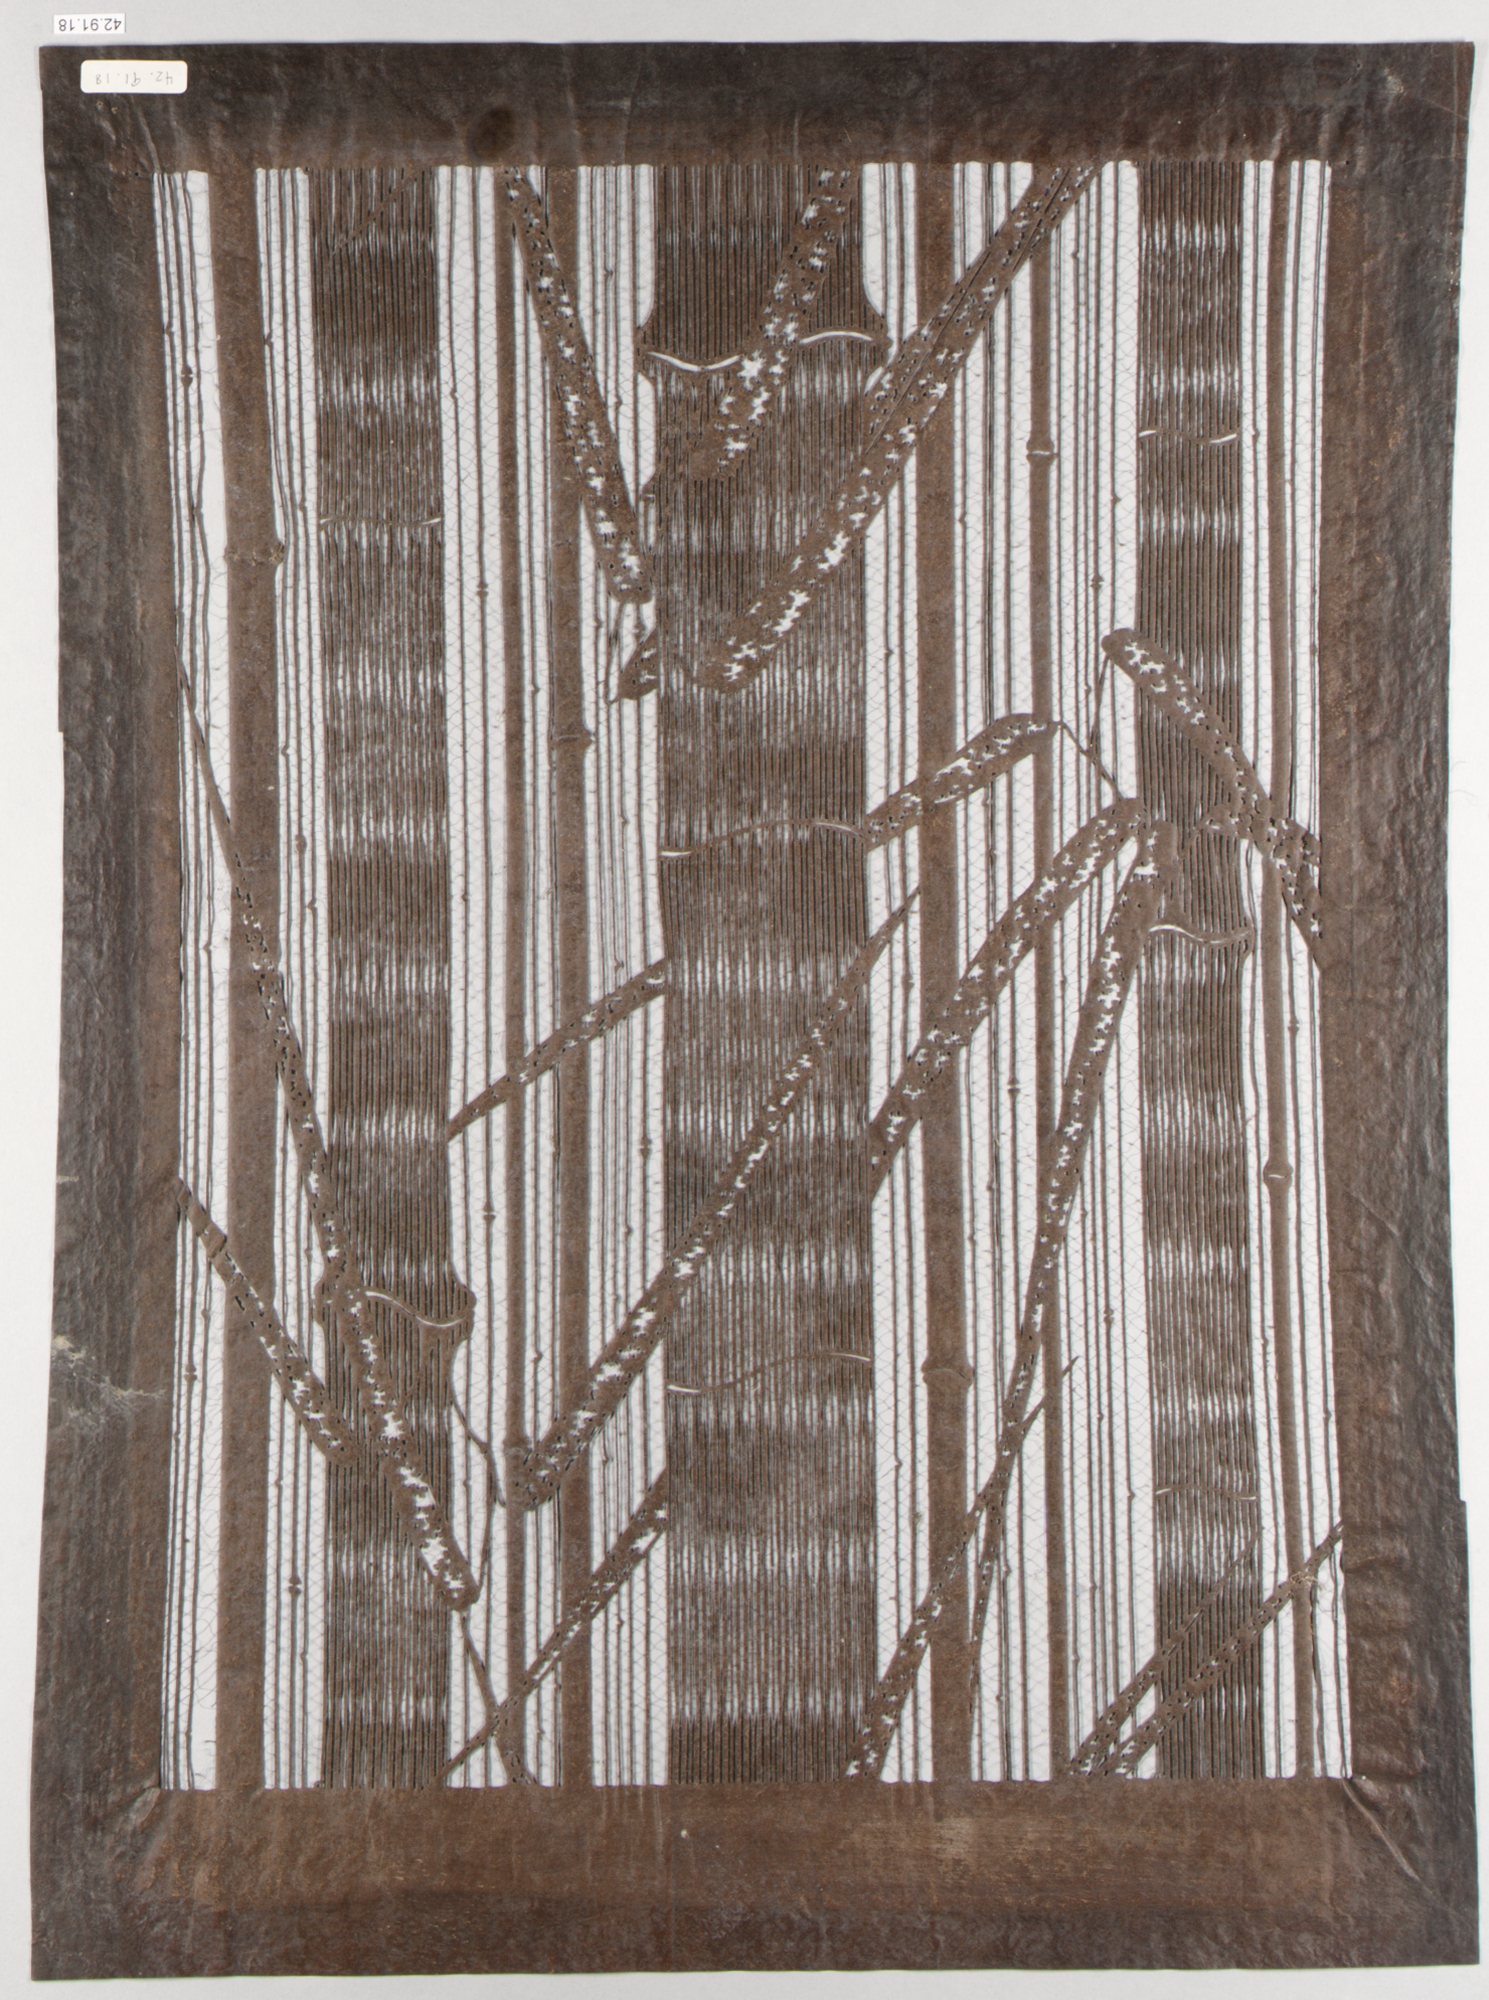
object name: stencil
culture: japanese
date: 1801-1900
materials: paper, silk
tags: bamboo